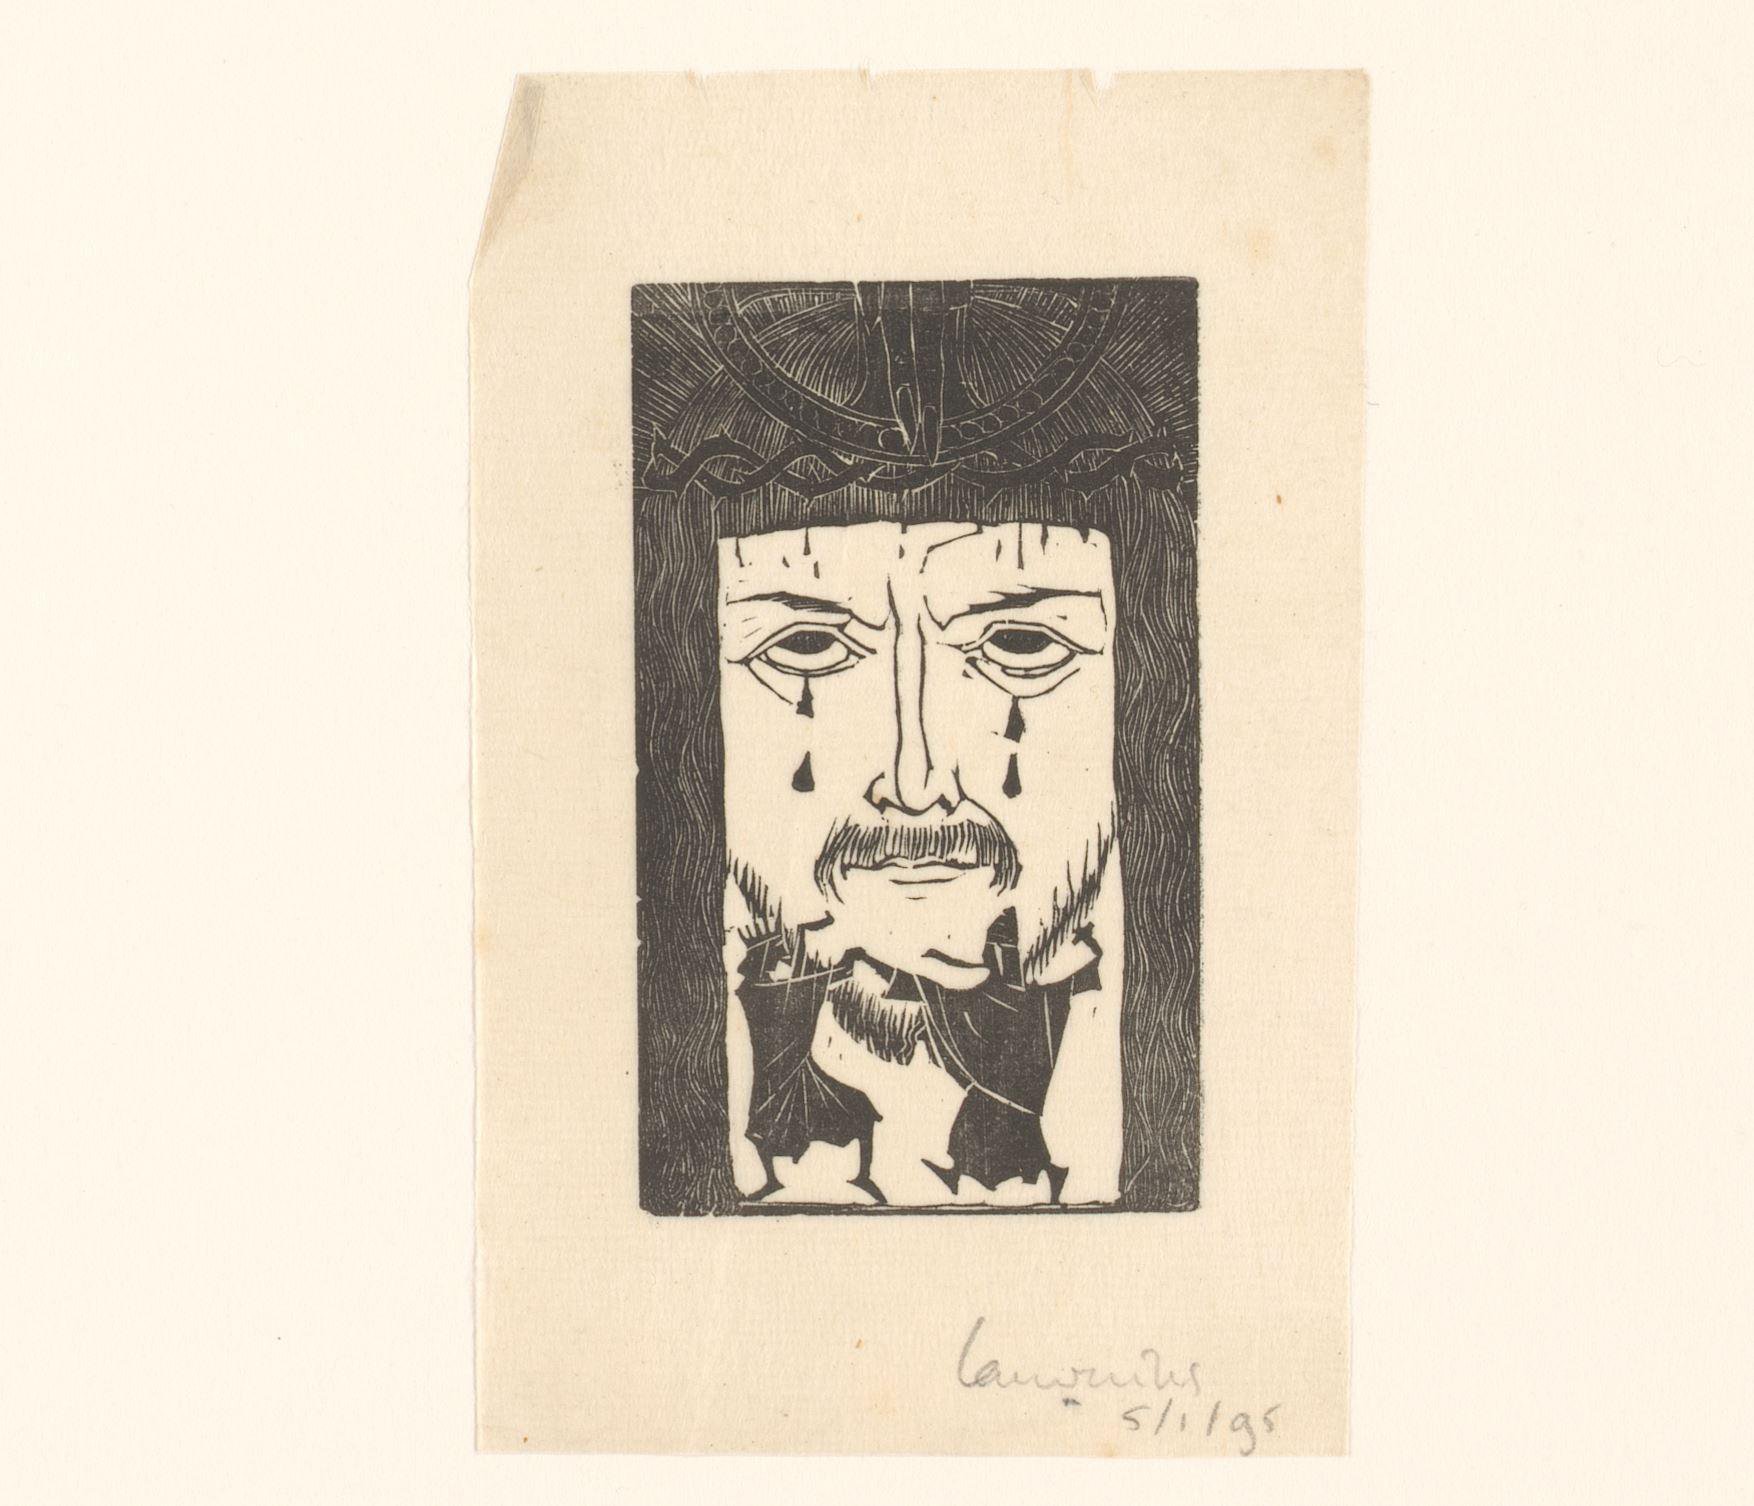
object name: print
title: Christus door Kerk en wereld bespot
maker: mathieu lauweriks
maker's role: designer, draughtsman, print maker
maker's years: 1864-1932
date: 1895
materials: paper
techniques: woodcut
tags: personifications of countries, nations, states, districts, etc., the church personified, 'ecclesia', usually with chalice and banner, mockings of christ, who may be blindfolded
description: Het gezicht van een huilende Christus met doornenkroon. Voor hem dansen een paus en een koning, als personificaties van Kerk en Staat.